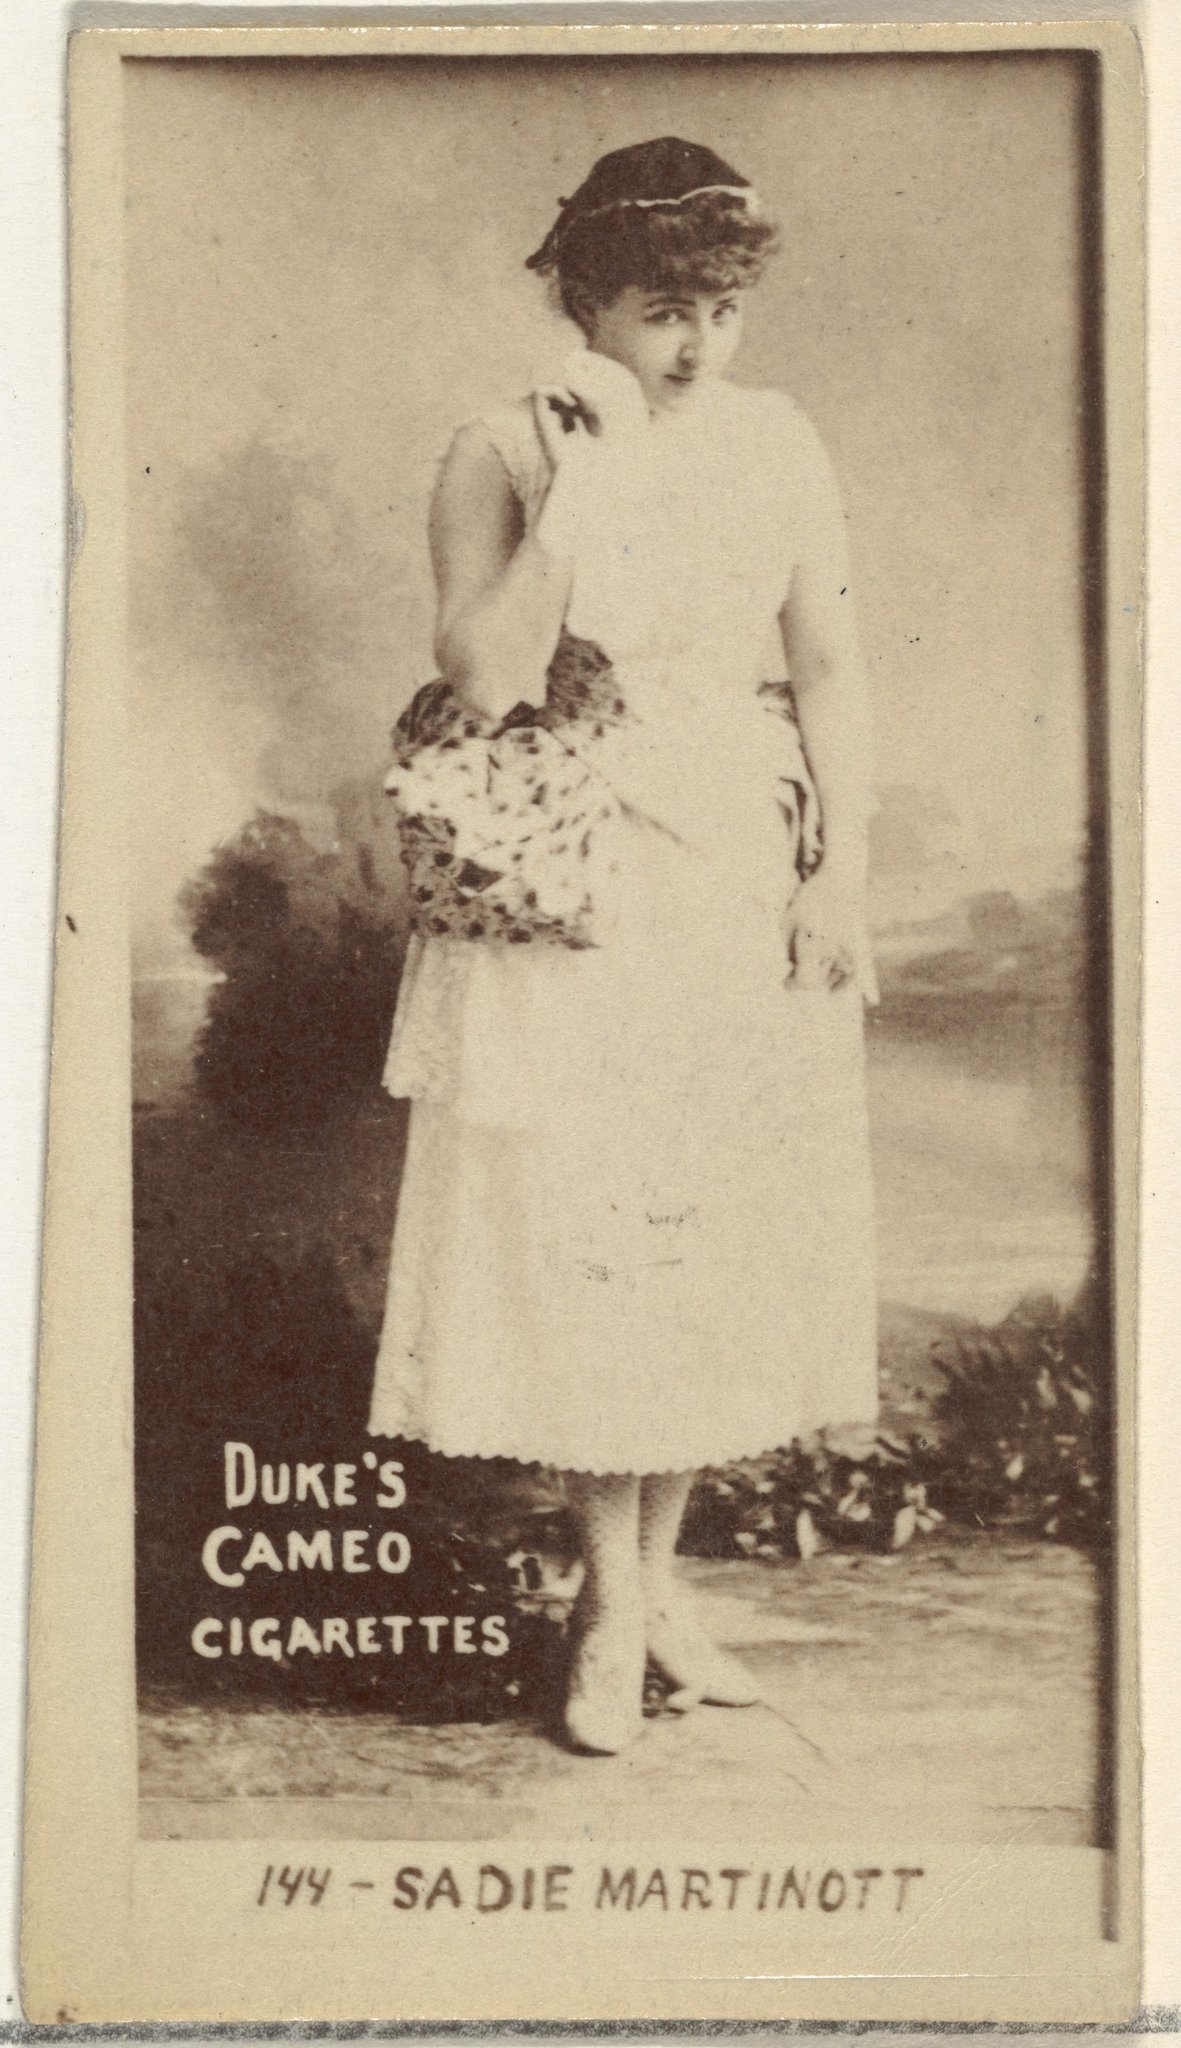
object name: photograph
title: Card Number 144, Sadie Martinot, from the Actors and Actresses series (N145-4) issued by Duke Sons & Co. to promote Cameo Cigarettes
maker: w. duke, sons & co.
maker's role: publisher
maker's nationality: american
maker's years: 1870-1920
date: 1880-1889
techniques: albumen silver print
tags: portraits,women,actresses